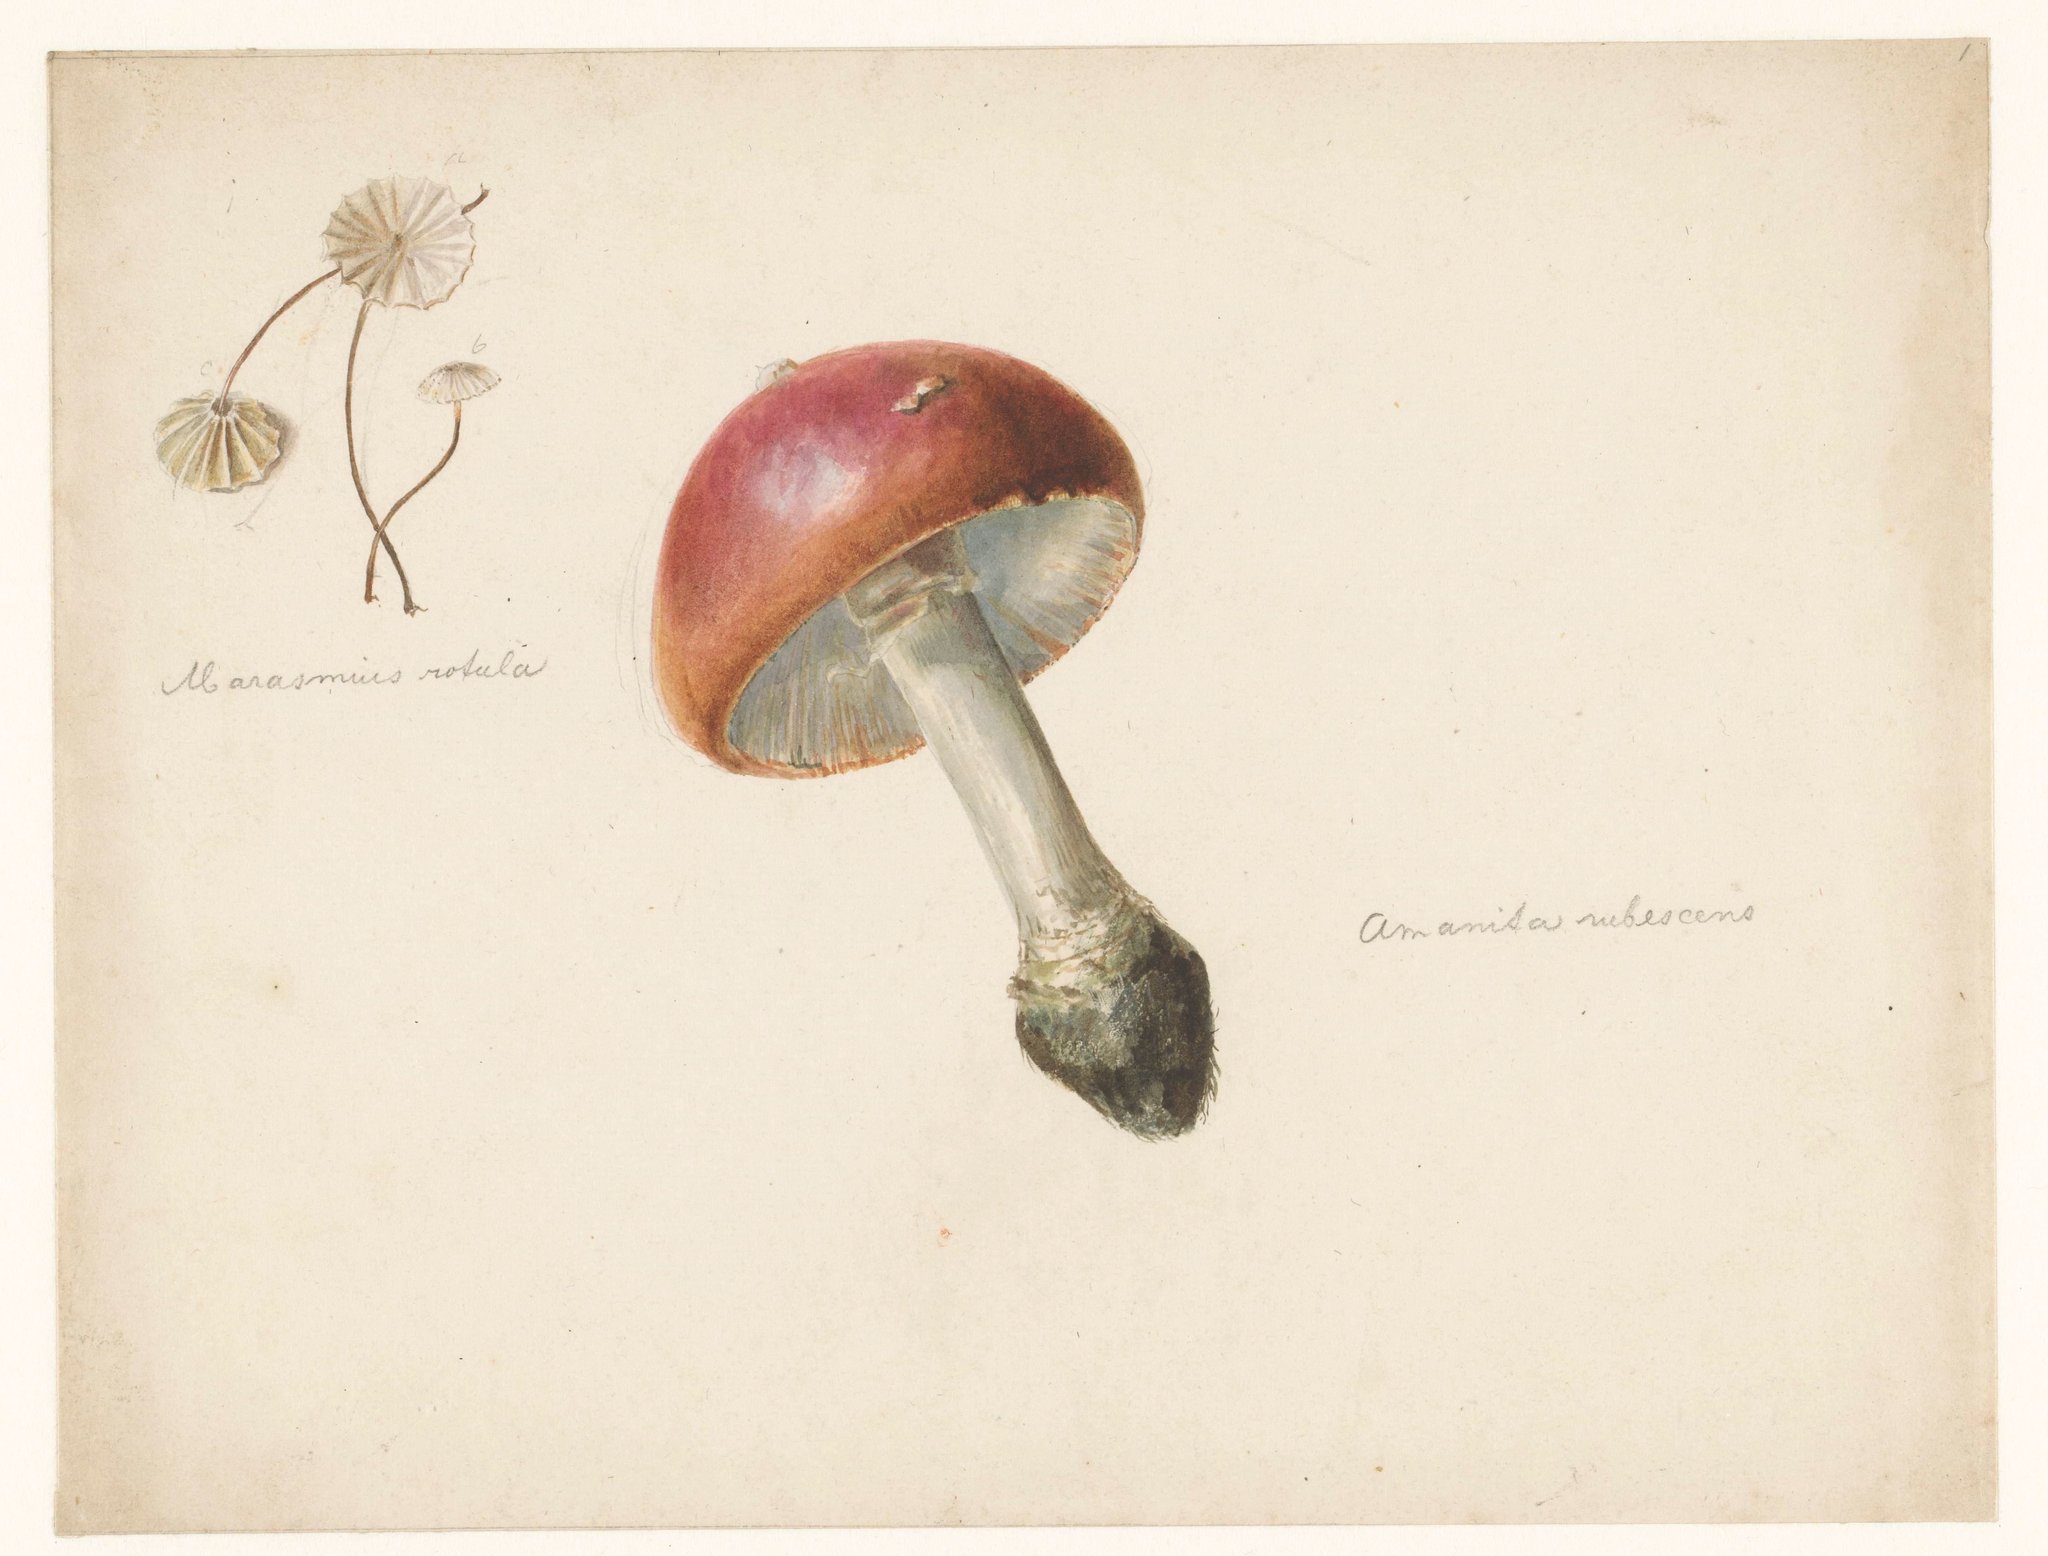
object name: drawing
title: Studieblad met paddestoelen, de Amanita Rubescens en de Marasmius Rotula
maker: albertus steenbergen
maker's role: draughtsman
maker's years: 1814-1900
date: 1824-1900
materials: paper, pencil, watercolor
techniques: brush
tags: mushrooms